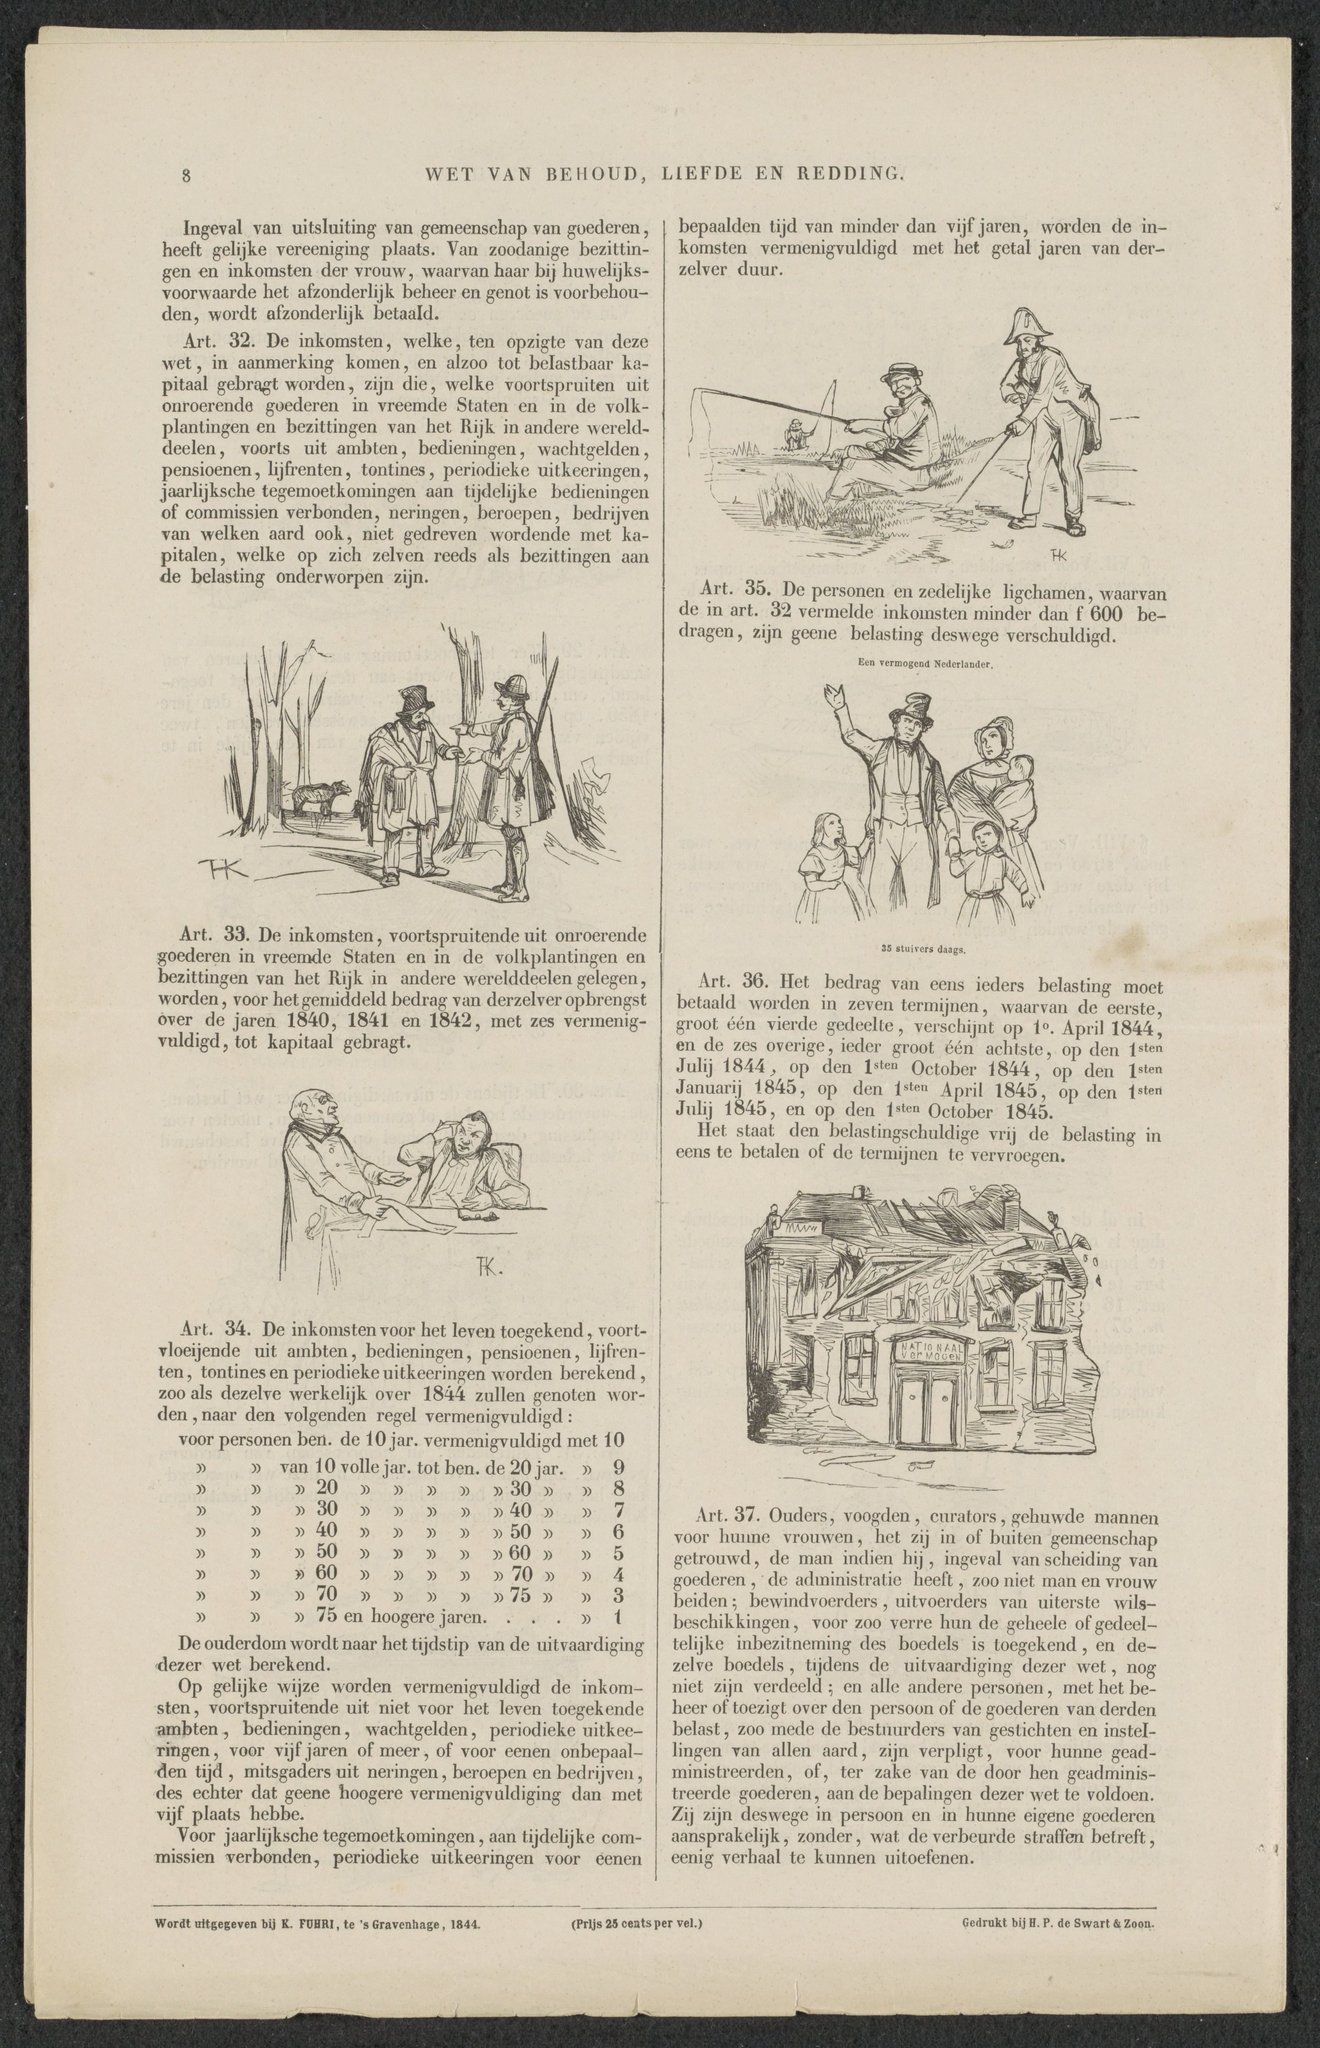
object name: print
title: Wet van Behoud, Liefde en Redding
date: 1844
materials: paper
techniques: letterpress printing, engraving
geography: netherlands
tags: amsterdam, the hague, floris adriaan van hall, organization of trade and finance, taxes and financial administration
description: Bladzijde 8 met artikels 32-37 van de 'Wet van Behoud, Liefde en Redding'. Een satire in zestien bladzijden op de aansporing tot deelneming in de (zogenaamde) vrijwillige 3% geldlening uitgeschreven in maart 1844 door minister F.A. van Hall. Achterzijde van een dubbelgevouwen blad bedrukt op alle zijden.